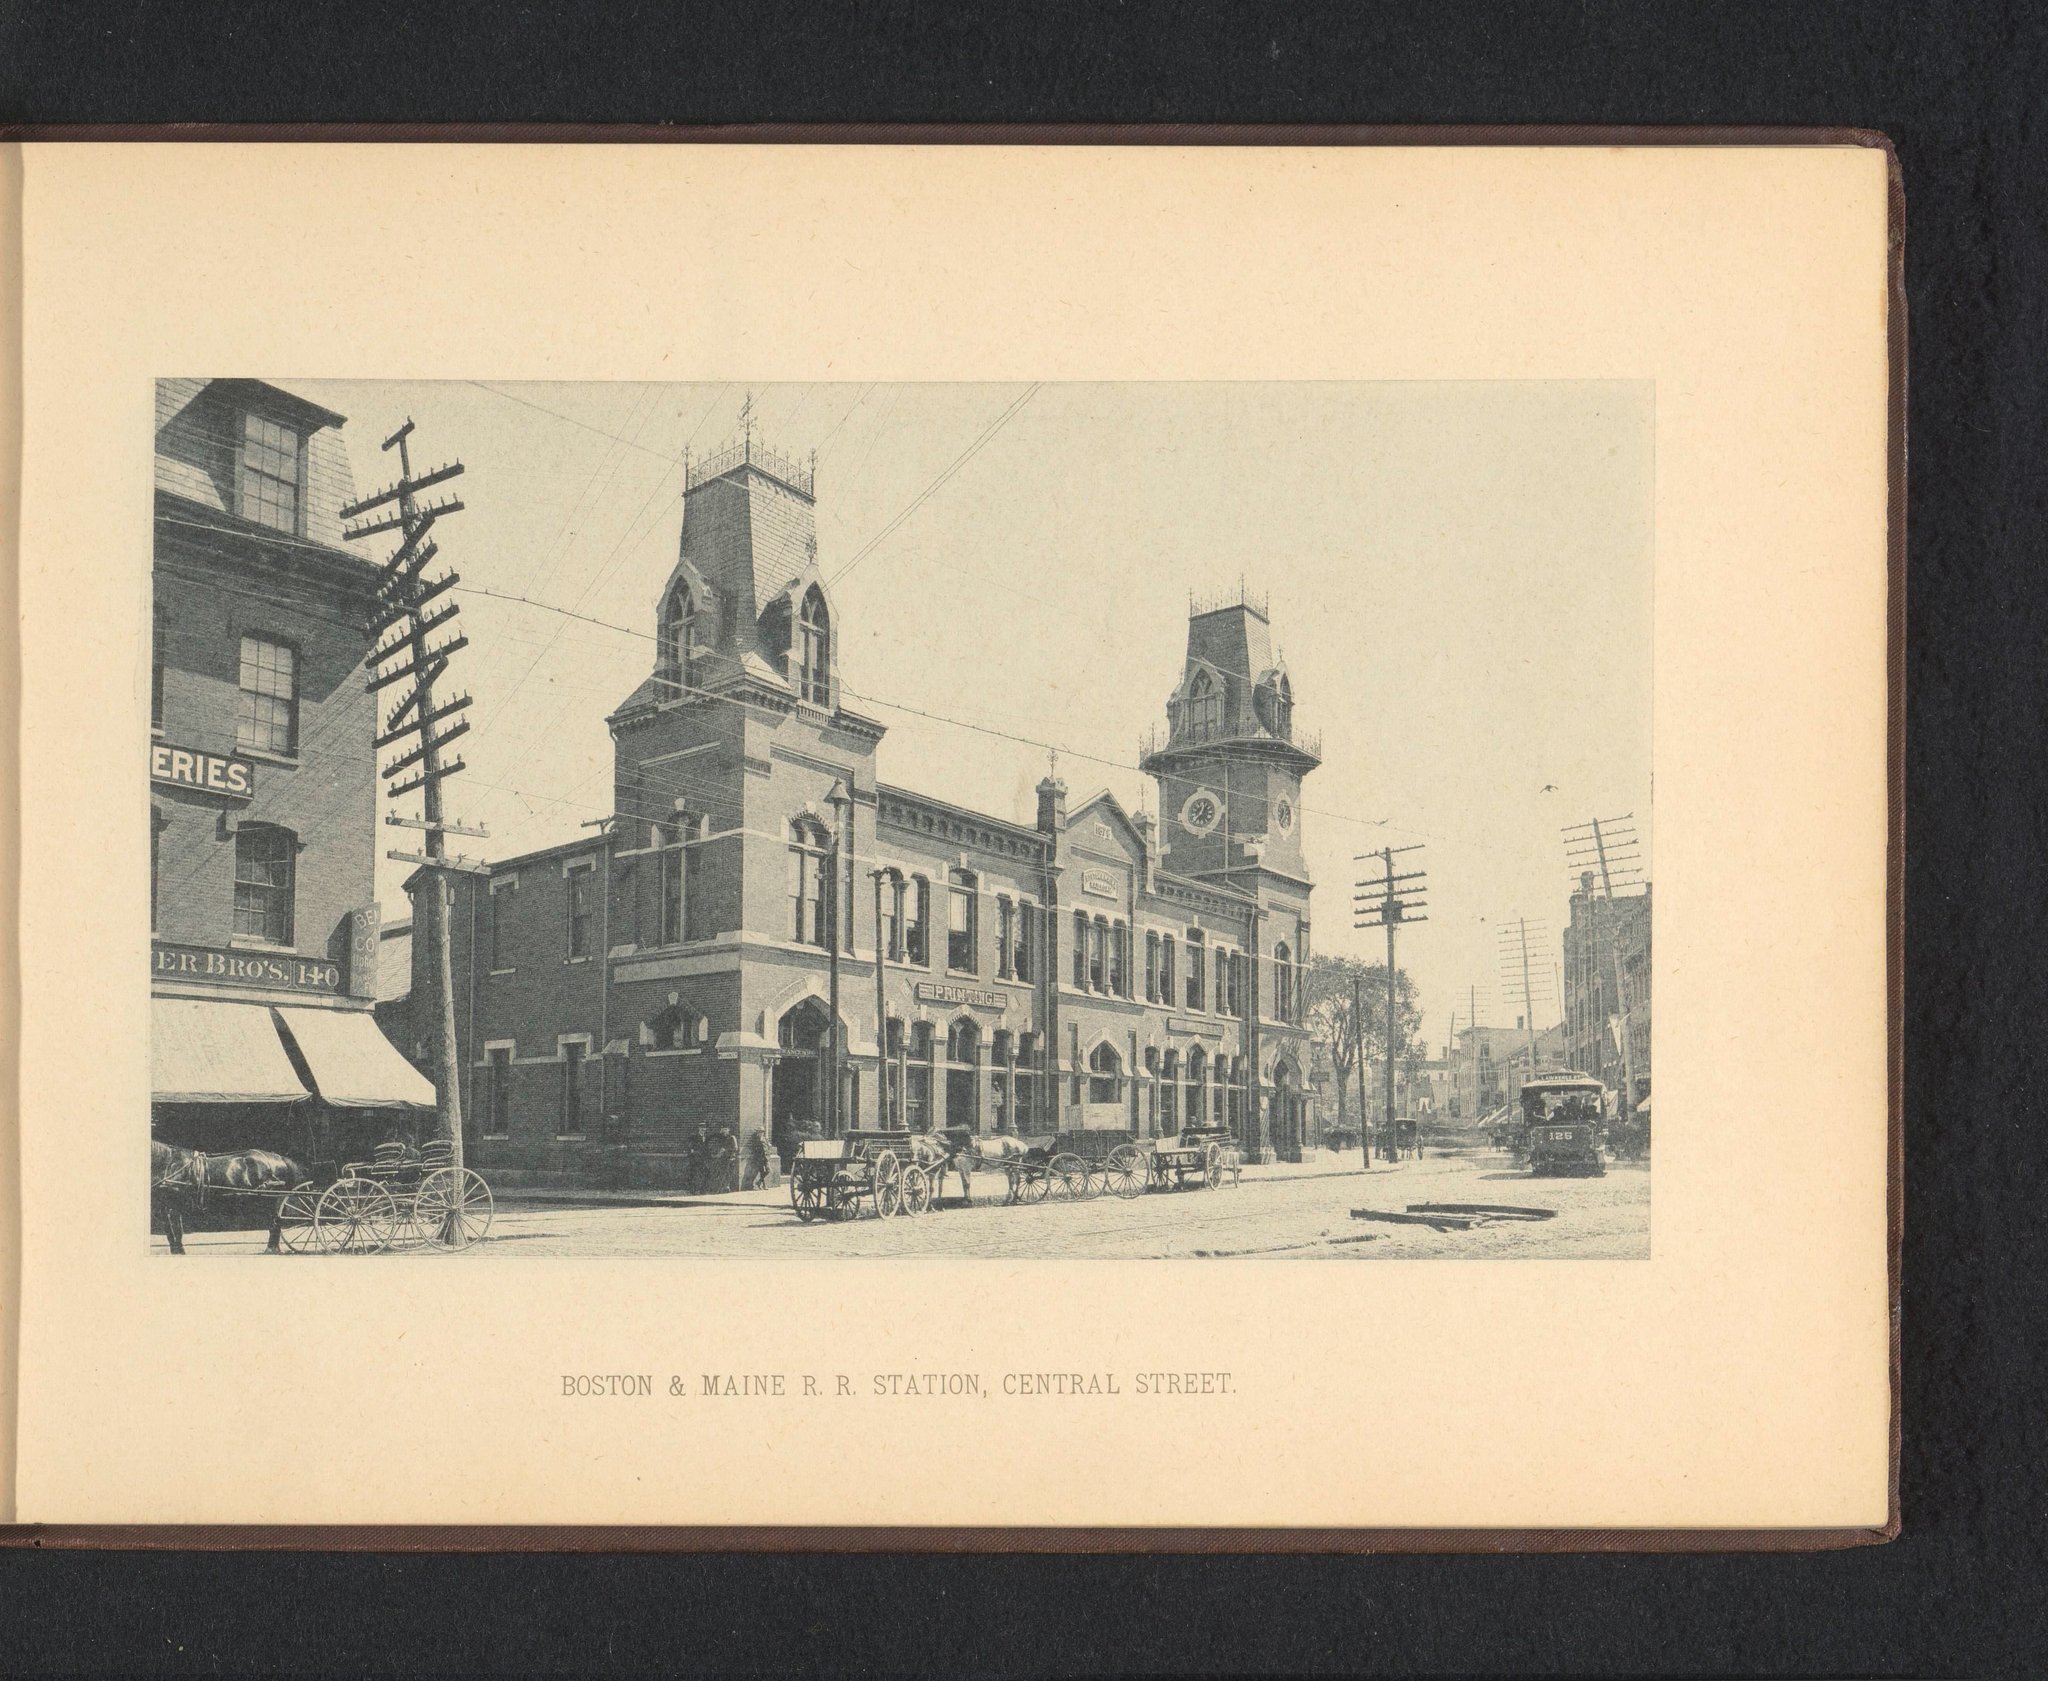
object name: photomechanical print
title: Bosten & Maine R.R. station, Central street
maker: Anonymous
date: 1887-1892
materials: paper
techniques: photograph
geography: lowell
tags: station; shelter (railway, tramway), street